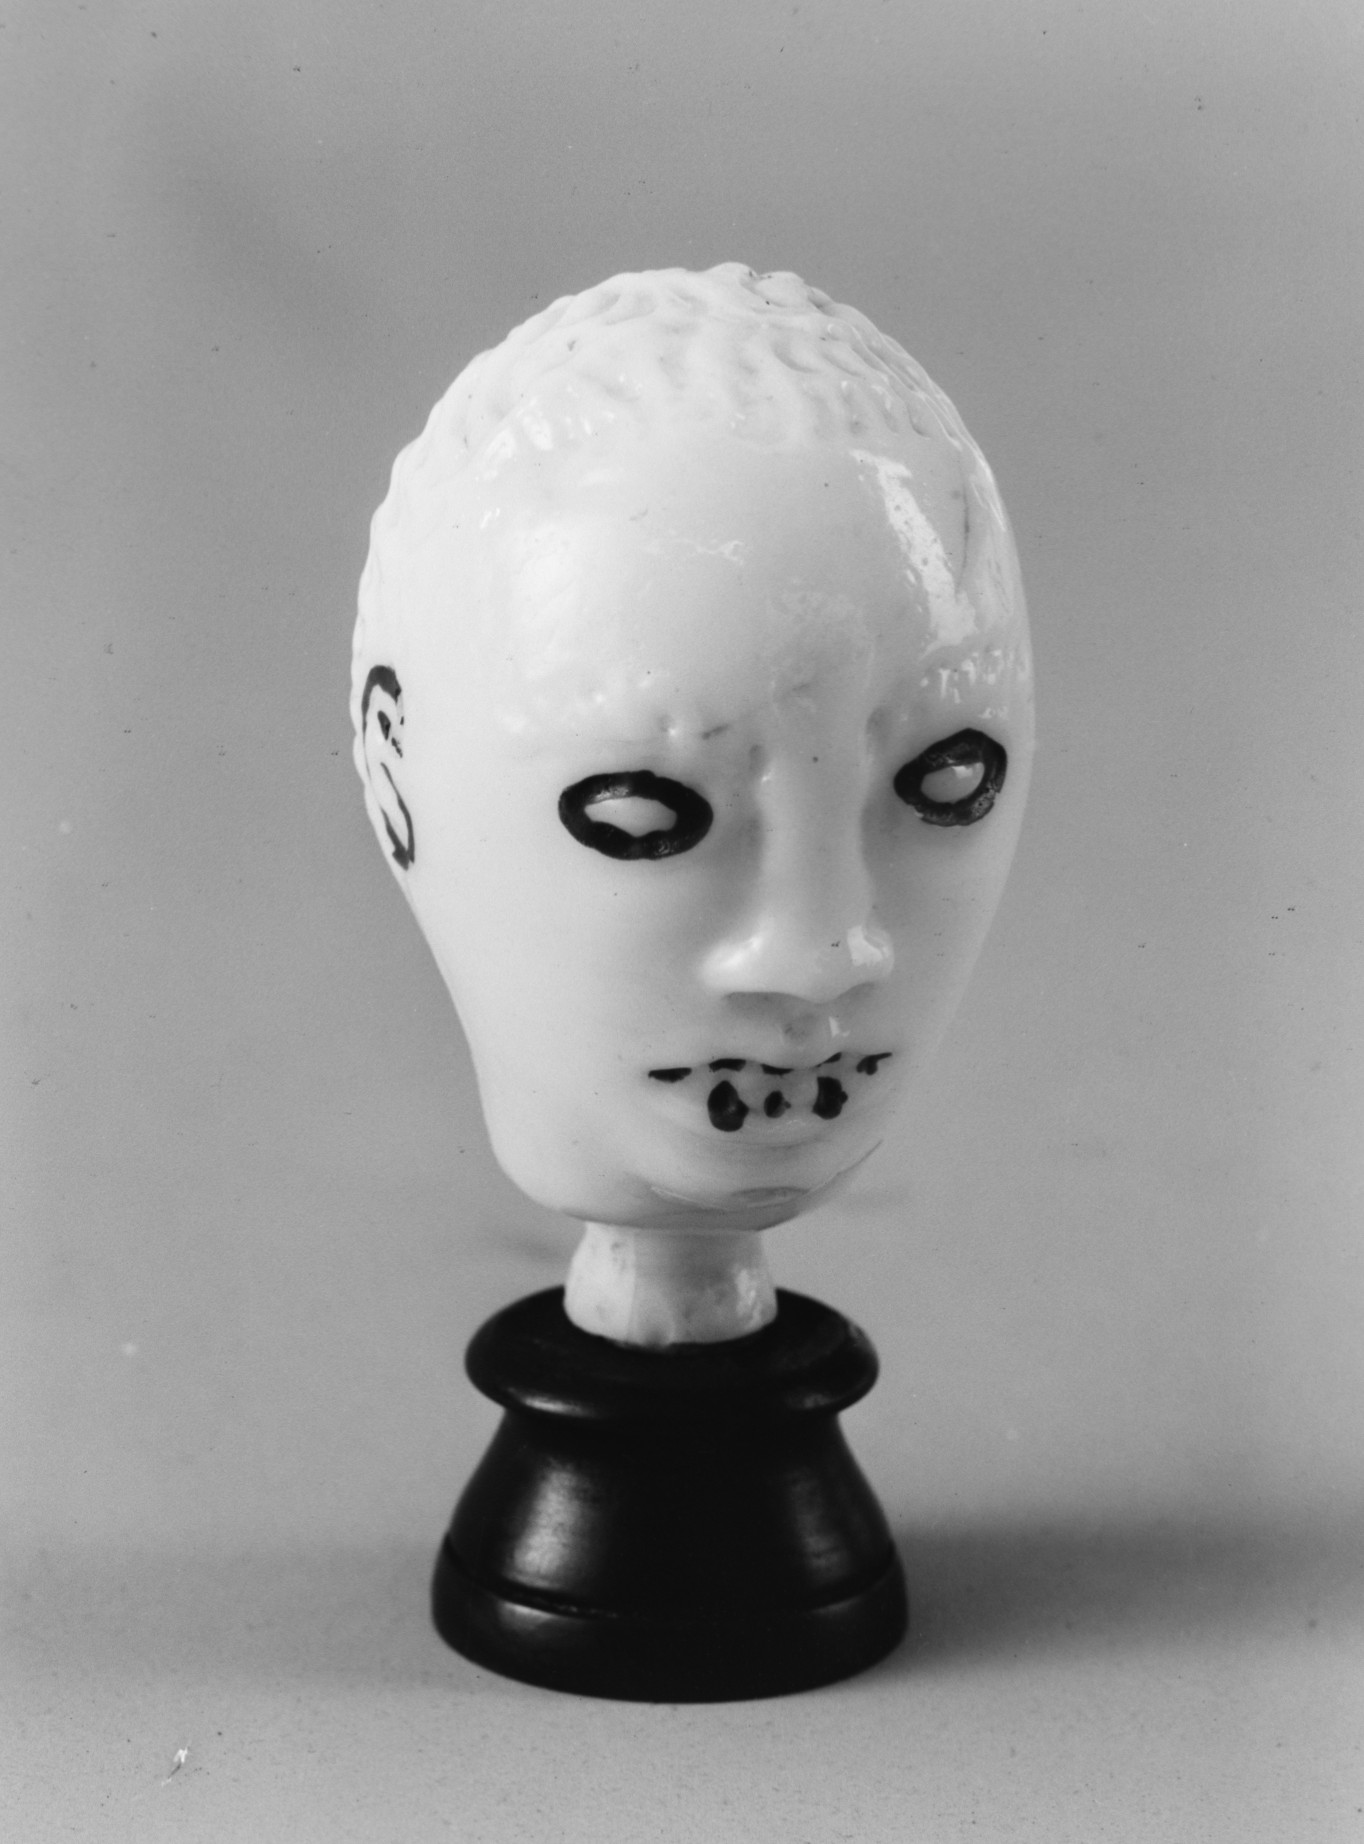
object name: flacon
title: Head-shaped flacon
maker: glasshouse of bernard perrot, verrerie royale d'orléans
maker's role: maker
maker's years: 1640-1709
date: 1700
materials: glass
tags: heads